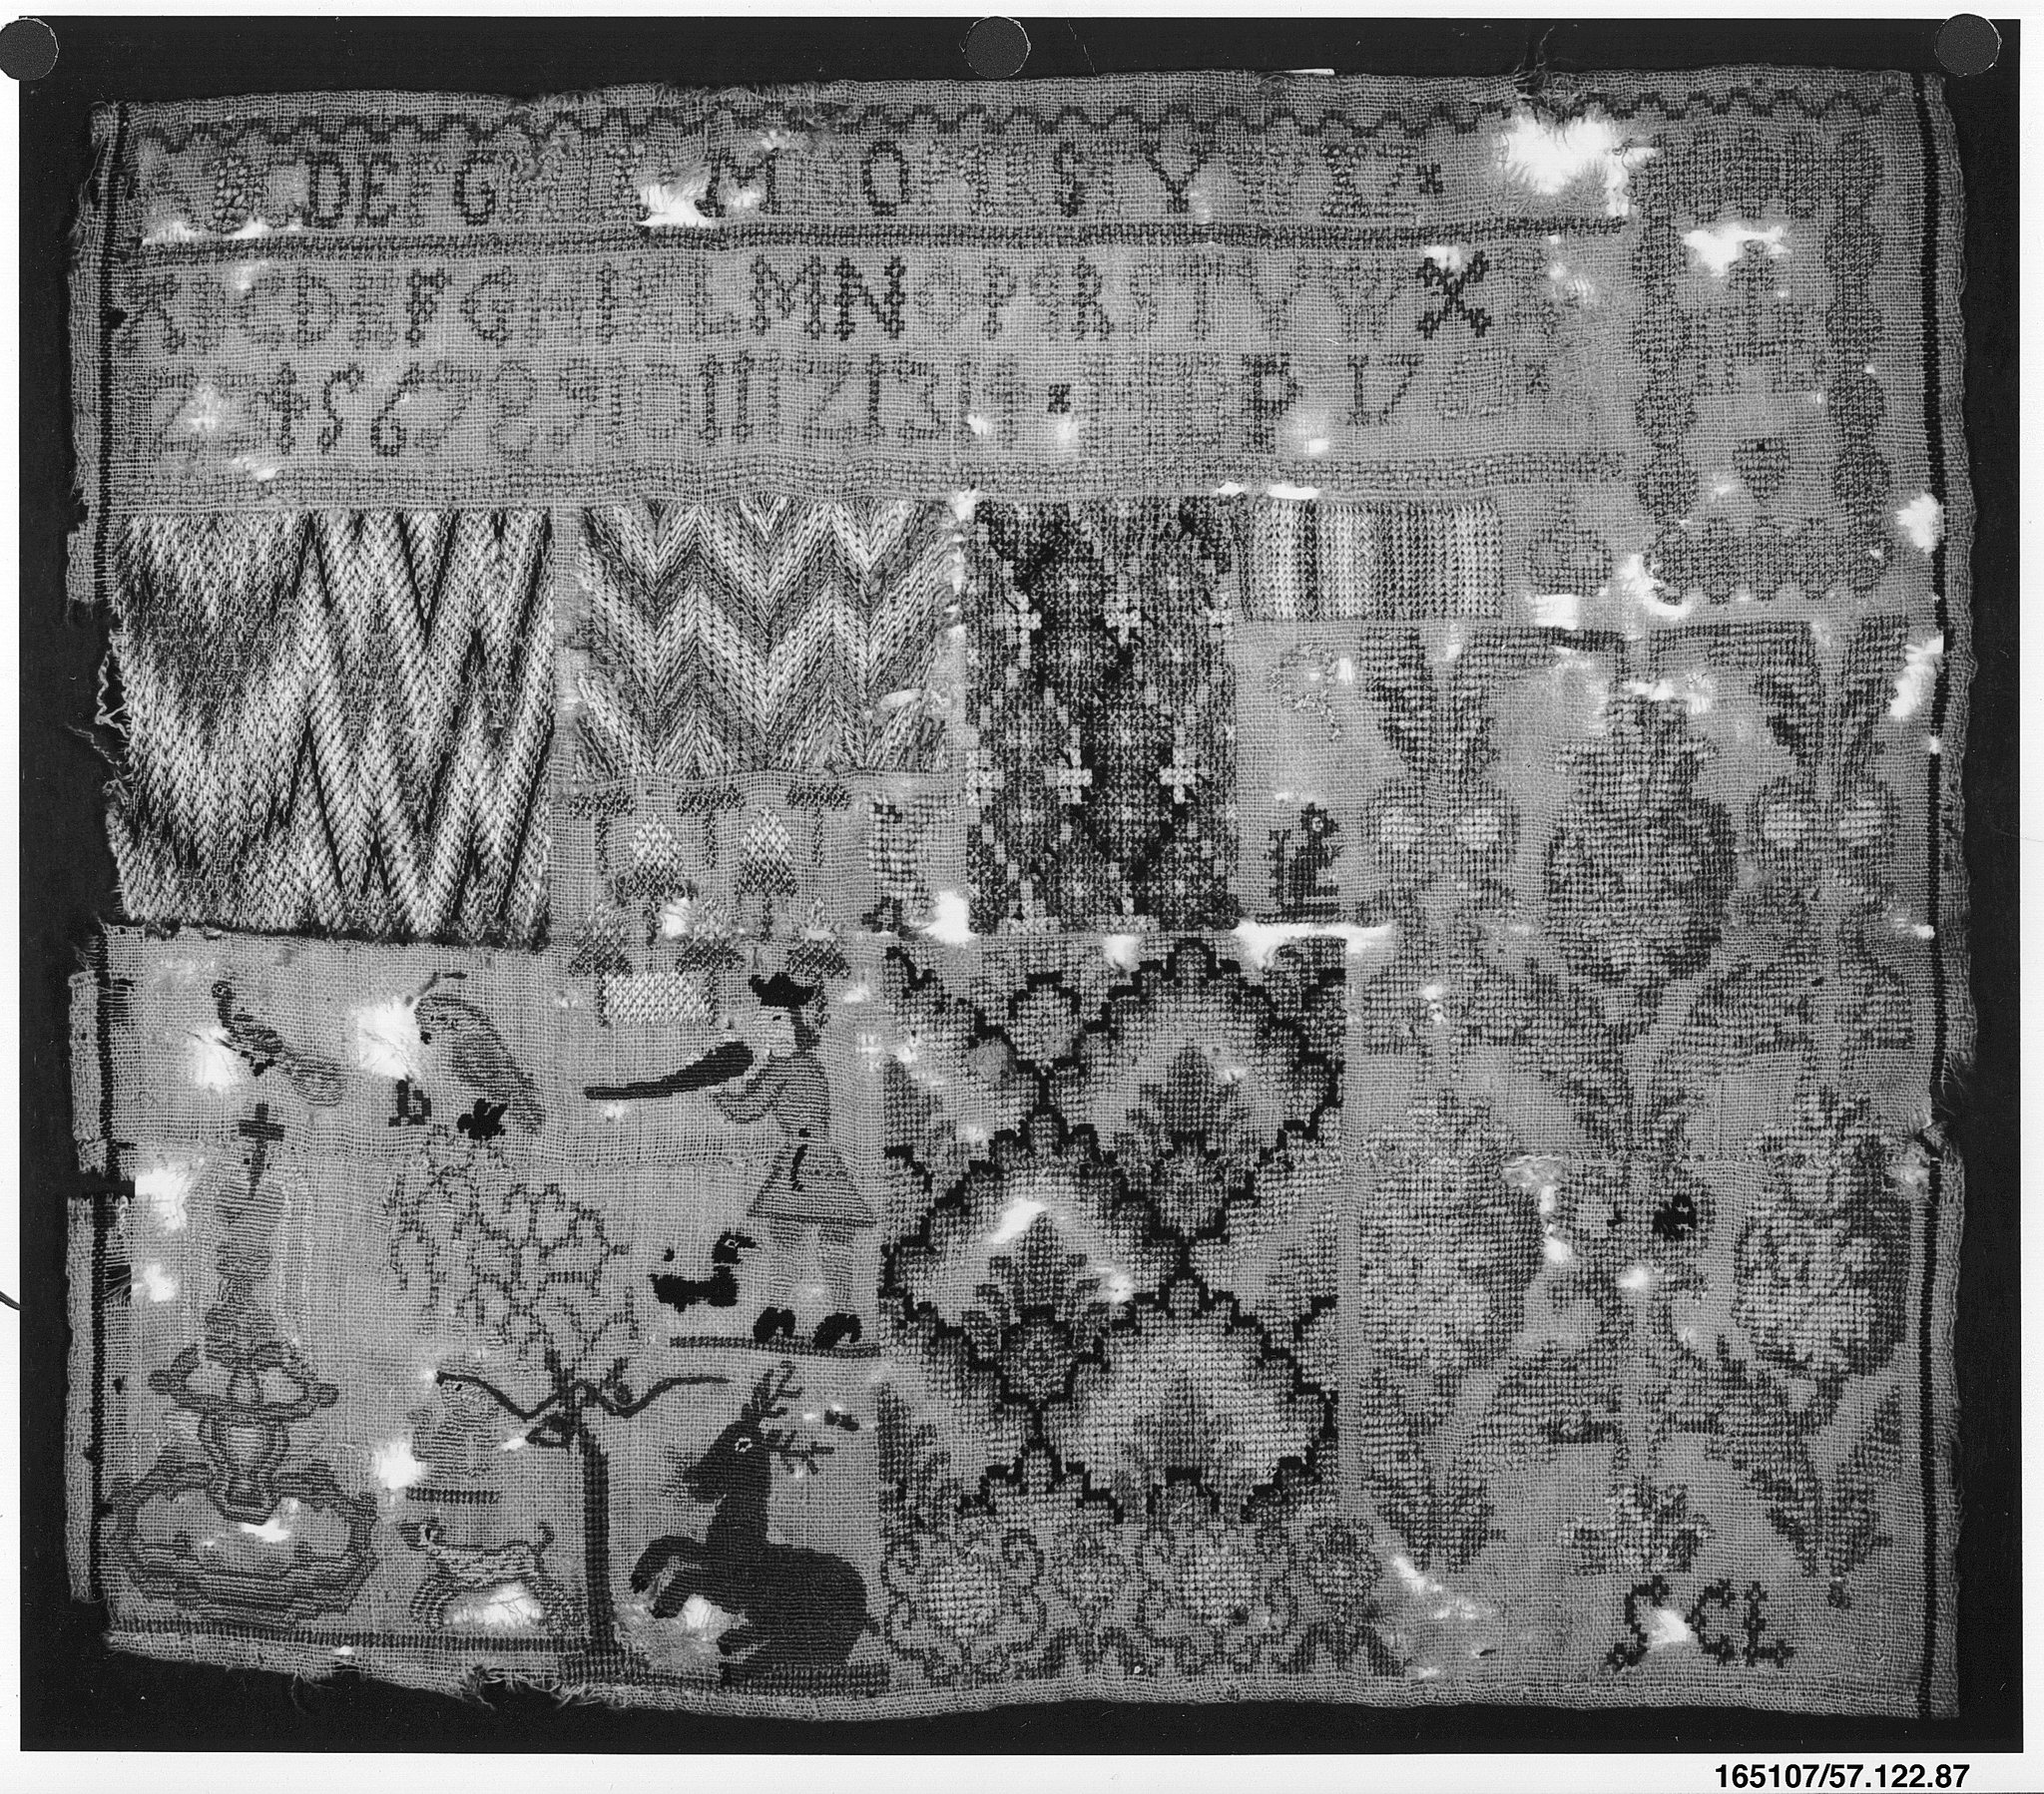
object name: sampler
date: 1763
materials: silk, wool